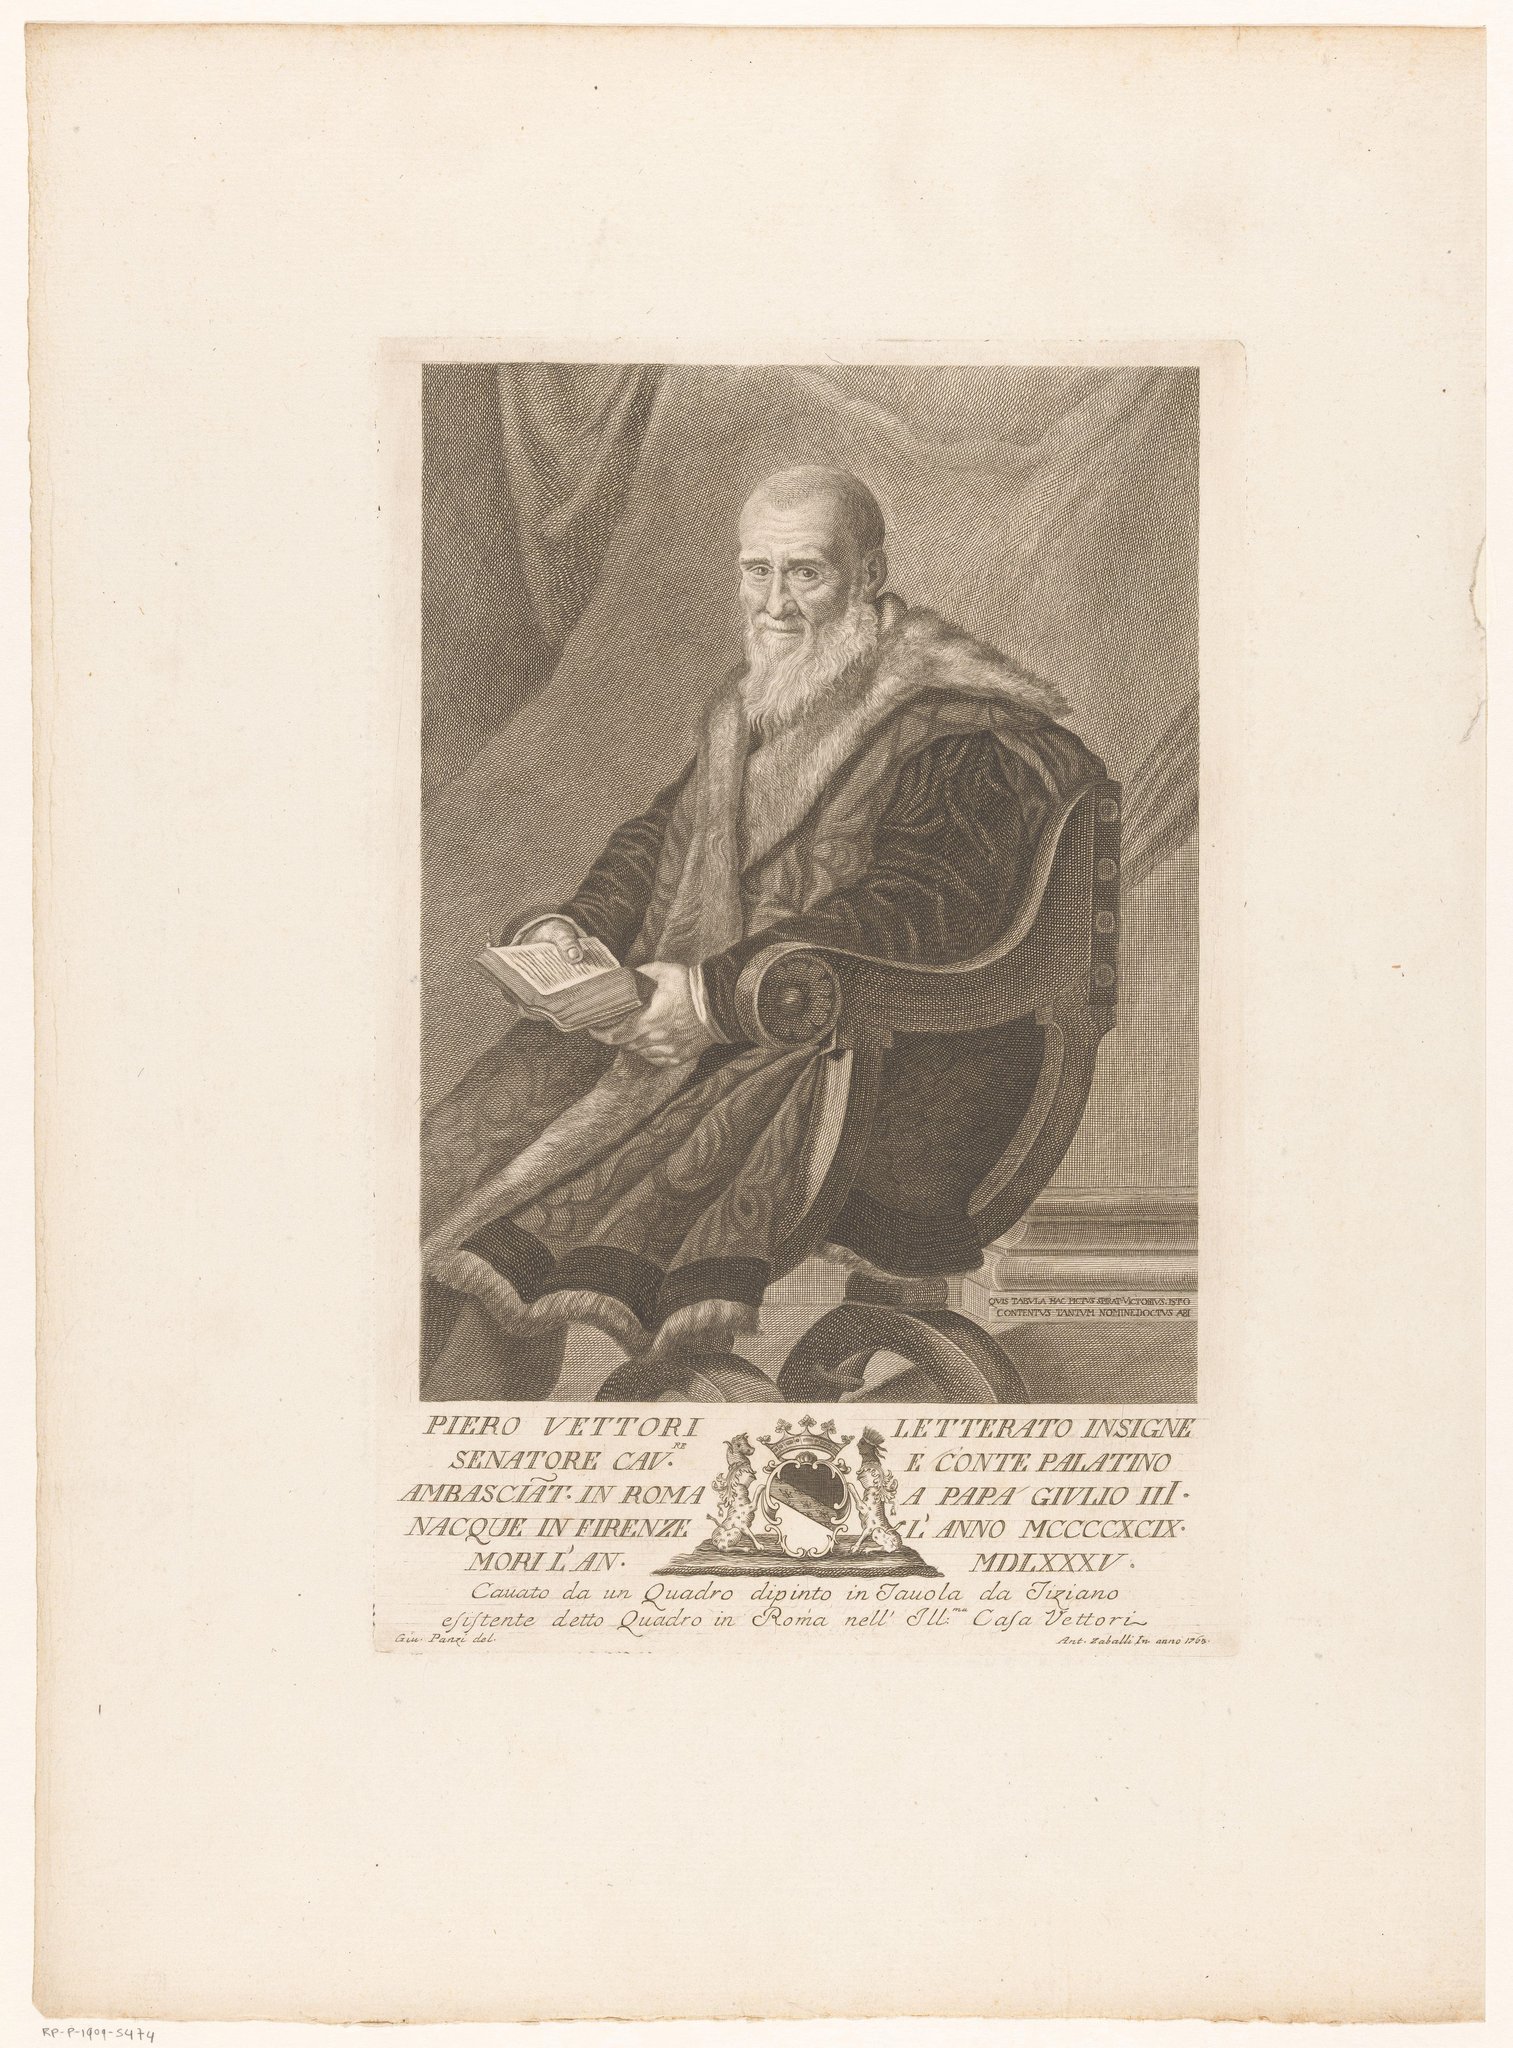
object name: print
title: Portretten van de familie Vettòri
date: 1763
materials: paper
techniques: engraving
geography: italy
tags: historical persons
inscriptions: collector's mark: Lugt 2228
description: Deze prent maakt deel uit van een serie van onbekende omvang met portretten van de familie Vettòri.